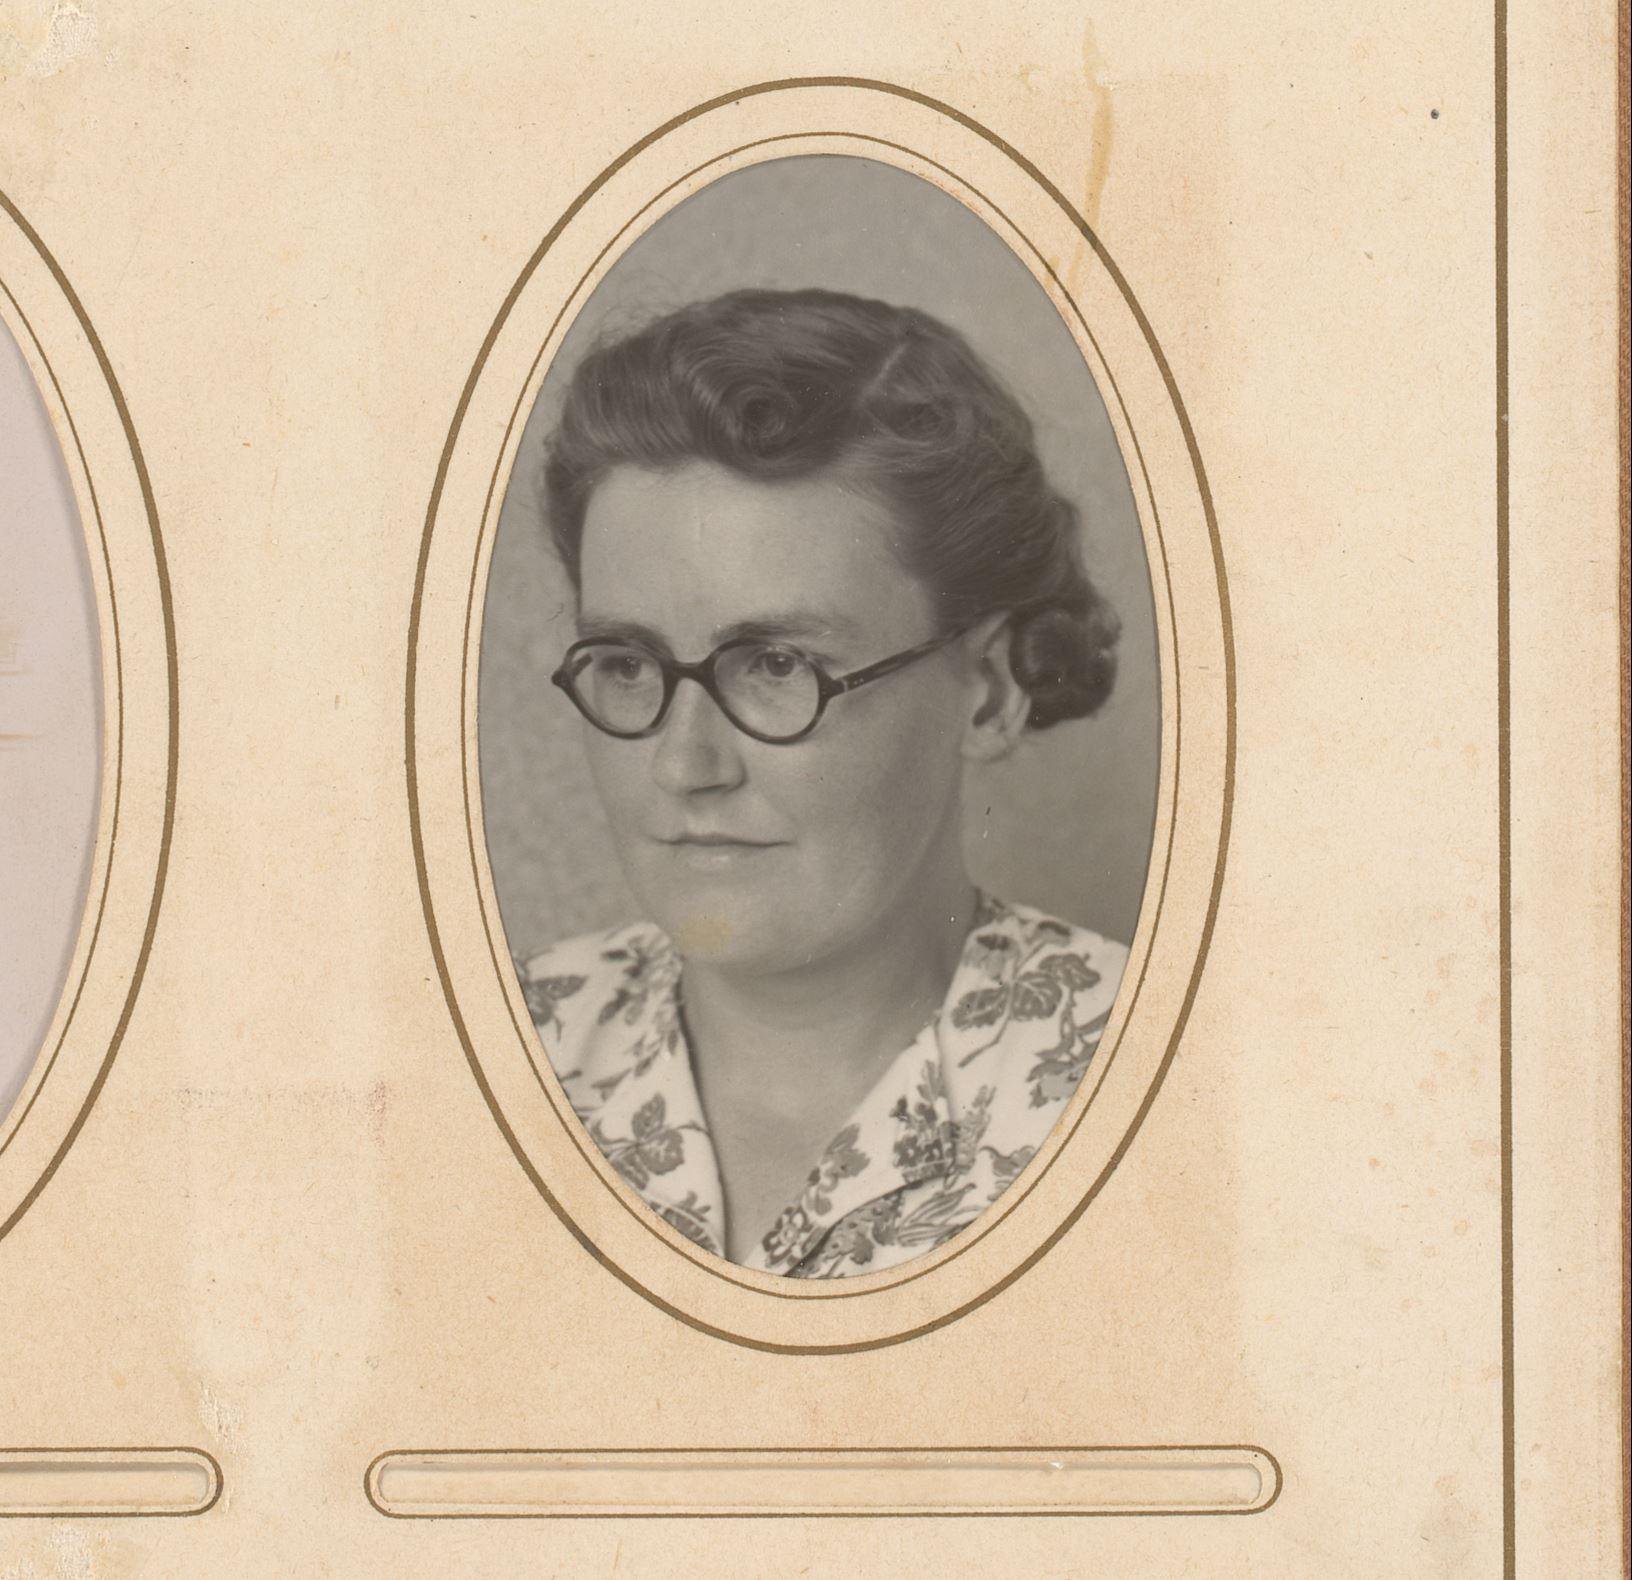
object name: photograph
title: Portret van een vrouw met bril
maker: Anonymous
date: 1905-1936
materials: cardboard, photographic support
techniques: gelatin silver print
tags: eyeglasses, spectacles, historical persons - bb - woman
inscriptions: inscription: ‘POST CARD/ CARTE POSTALE/ Communication-Correspondance Adress-Adresse’